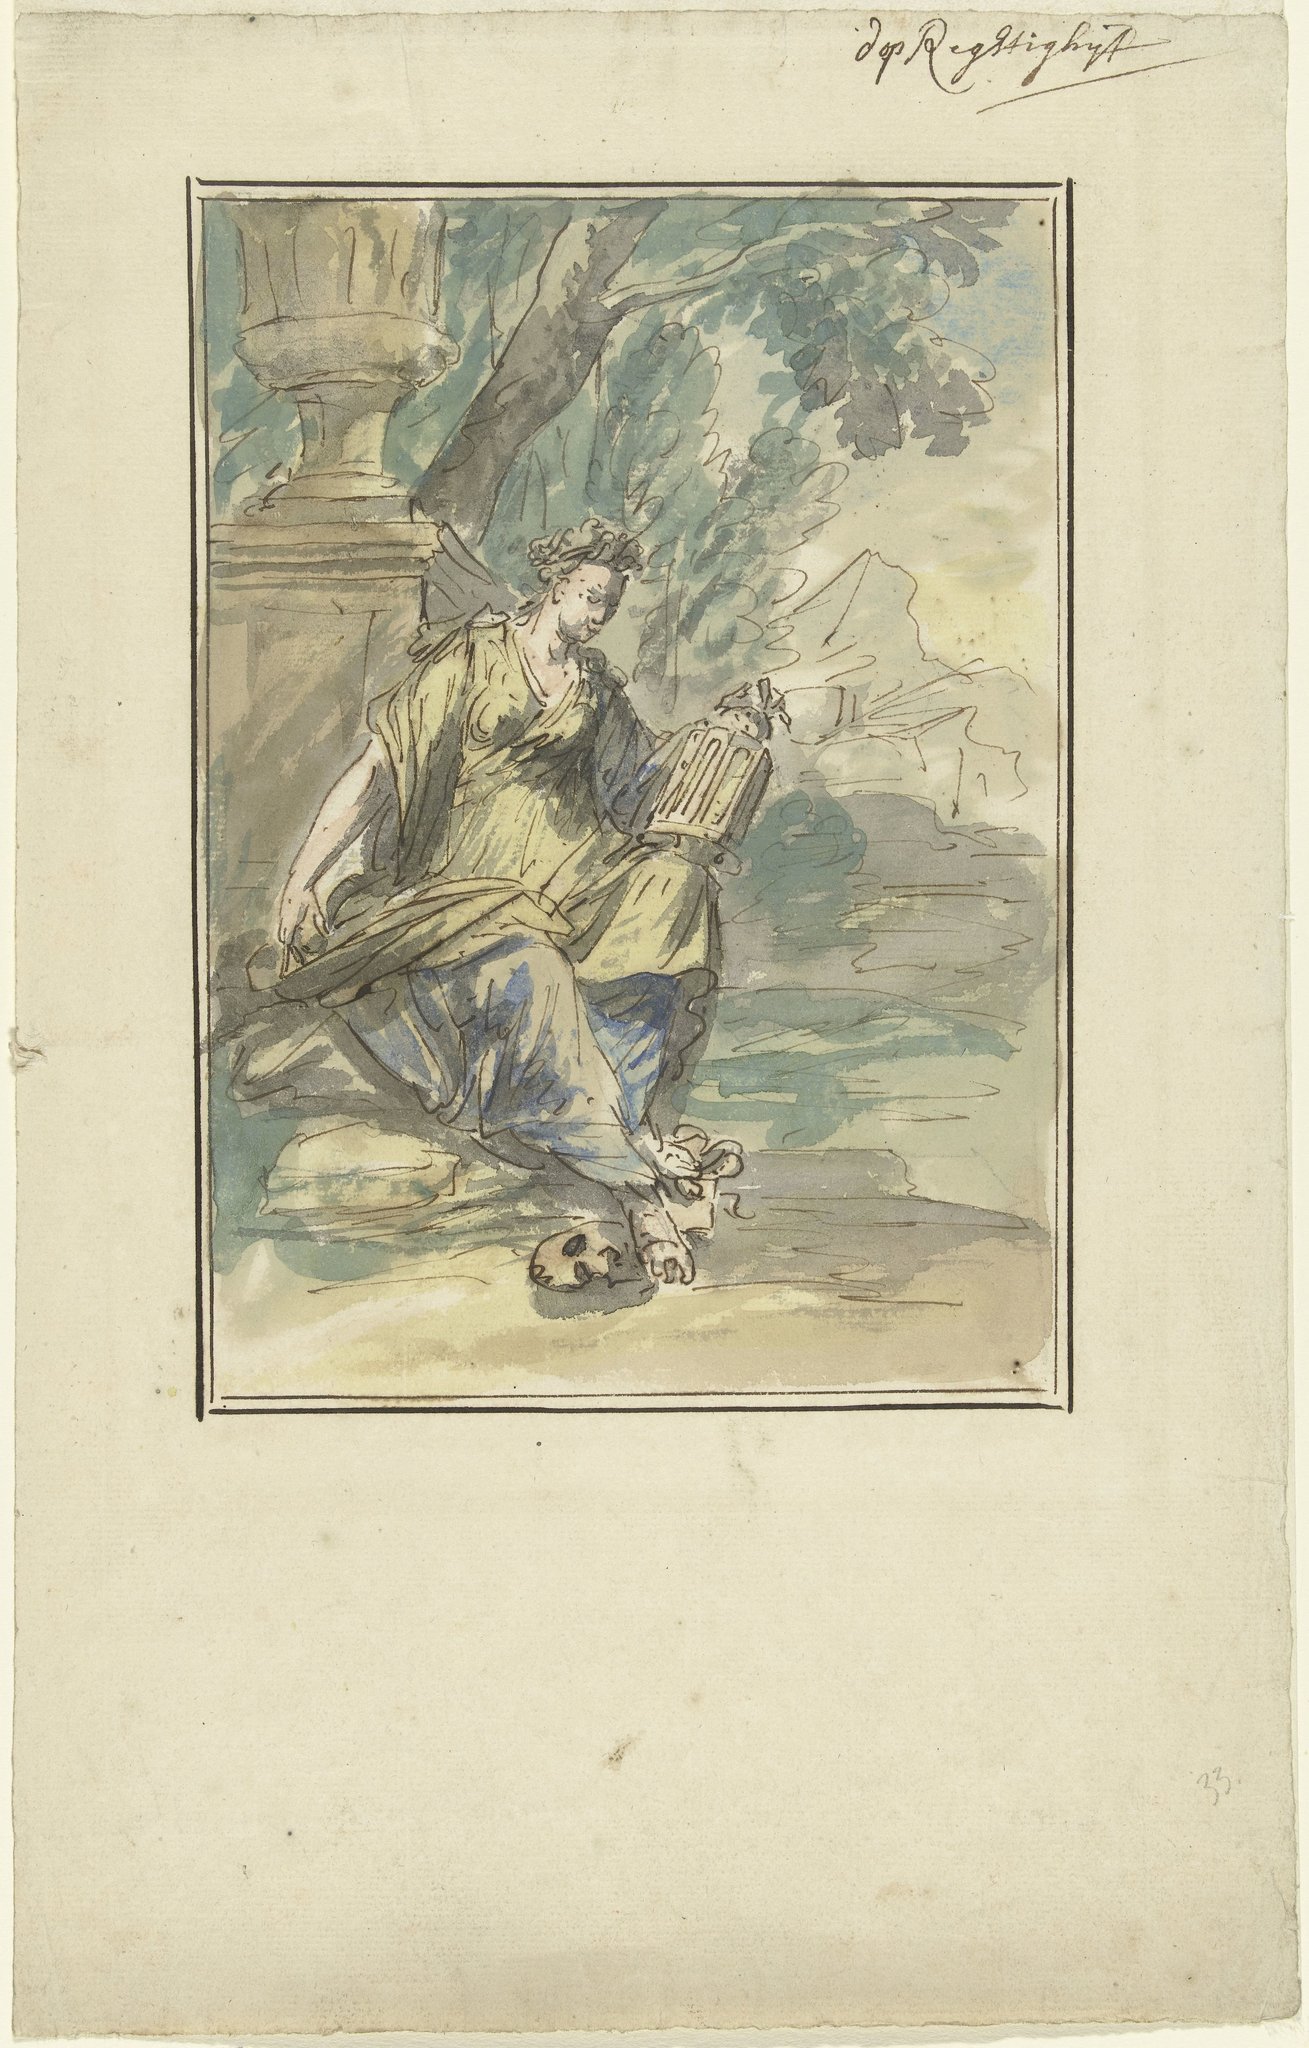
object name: design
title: De Oprechtheid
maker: elias van nijmegen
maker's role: draughtsman, painter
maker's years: 1667-1755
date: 1677-1755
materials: ink, paper, pencil, watercolor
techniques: brush, pen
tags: sincerity; 'purità et sincerità d'animo', 'sincerità' (ripa) (+ abstract concept represented by female figure)